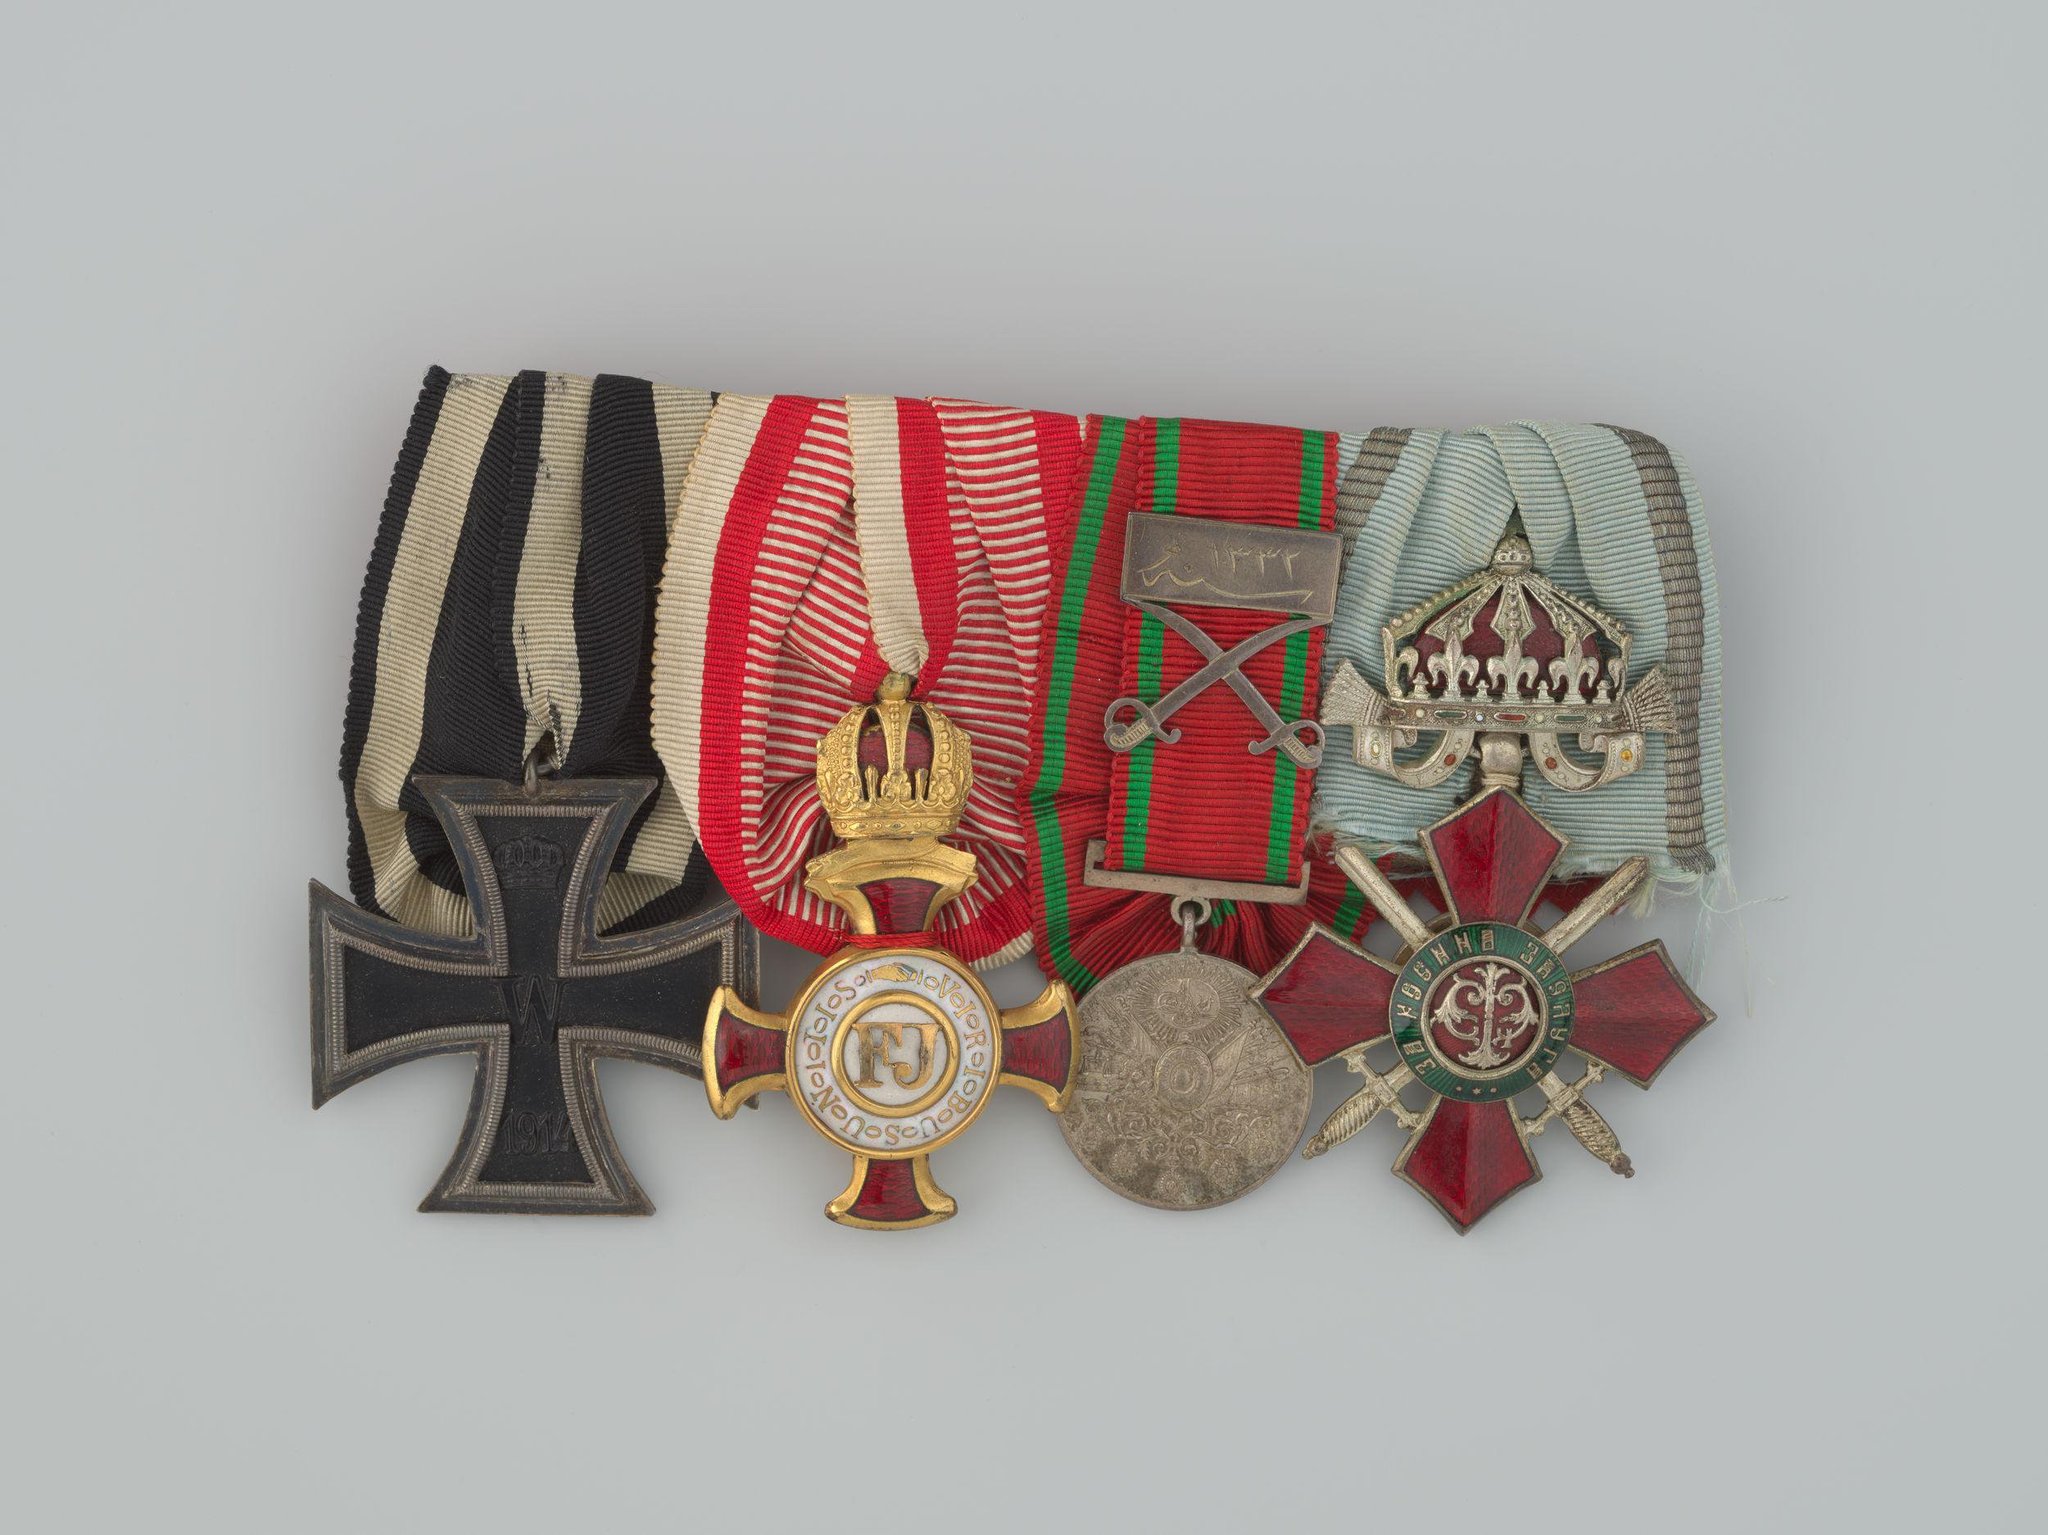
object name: ordeteken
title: Bulgaarse Militaire Orde van Verdienste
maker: Anonymous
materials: silk, silver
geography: turkey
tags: eugen wachenheimer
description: Dit object is onderdeel van de nalatenschap van Isabel Elon-Wachenheimer (1928-2010). Tot haar overlijden behoorde het samen met de andere objecten uit de nalatenschap tot haar privédomein van Isabel Wachenheimer. In die particuliere context zijn deze objecten tezamen en individueel aandenkens - aan de jeugd, ouders en familie van Isabel Wachenheimer vóór en tijdens de Shoah en aan haar leven na de Tweede Wereldoorlog. Isabel Wachenheimer, die van juni 1943 tot mei 1945 gevangen zat in Kamp Westerbork, Theresienstadt, Auschwitz, Lenzing a/d Oberdonau (een buitenkamp van Mauthausen), overleefde de Shoah. Haar ouders – Eugène Wachenheimer en Else Wachenheimer-Moos - werden op 14 oktober 1944 in Auschwitz-Birkenau vermoord.